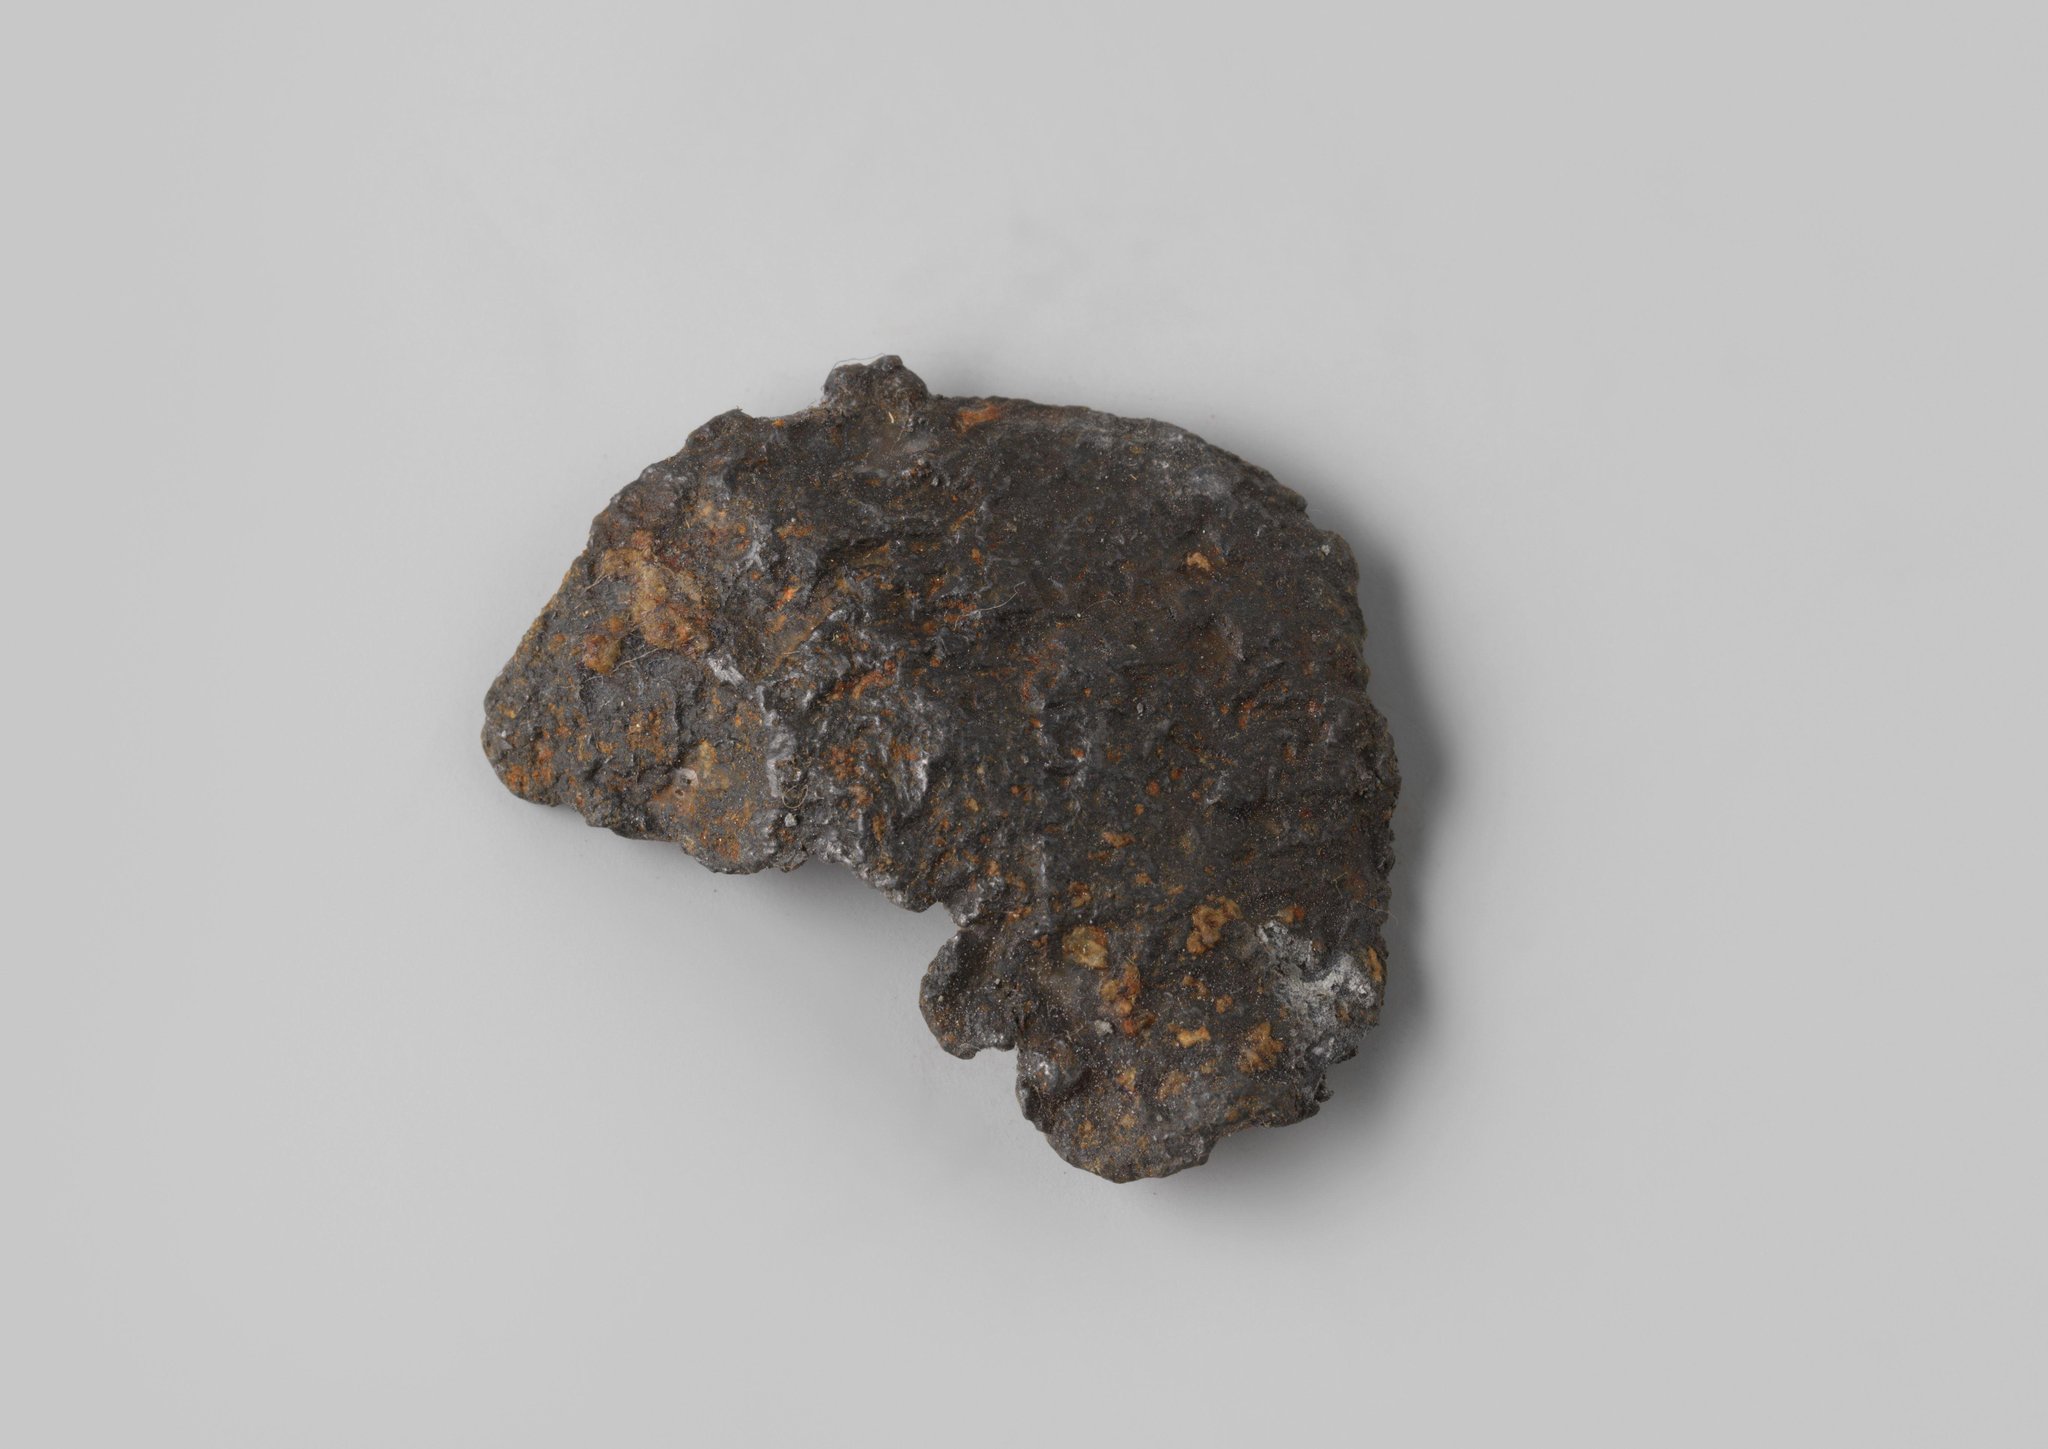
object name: musketkogel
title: Musketkogel uit het wrak van de Oost-Indiëvaarder Hollandia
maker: Anonymous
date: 1700-1743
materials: lead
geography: netherlands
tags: verenigde oostindische compagnie, hollandia (schip), annet